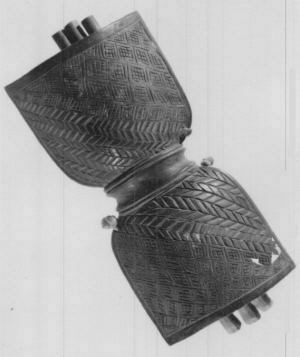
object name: kunda double bell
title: Kunda (Double Bell)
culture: congolese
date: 1867-1900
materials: wood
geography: congo